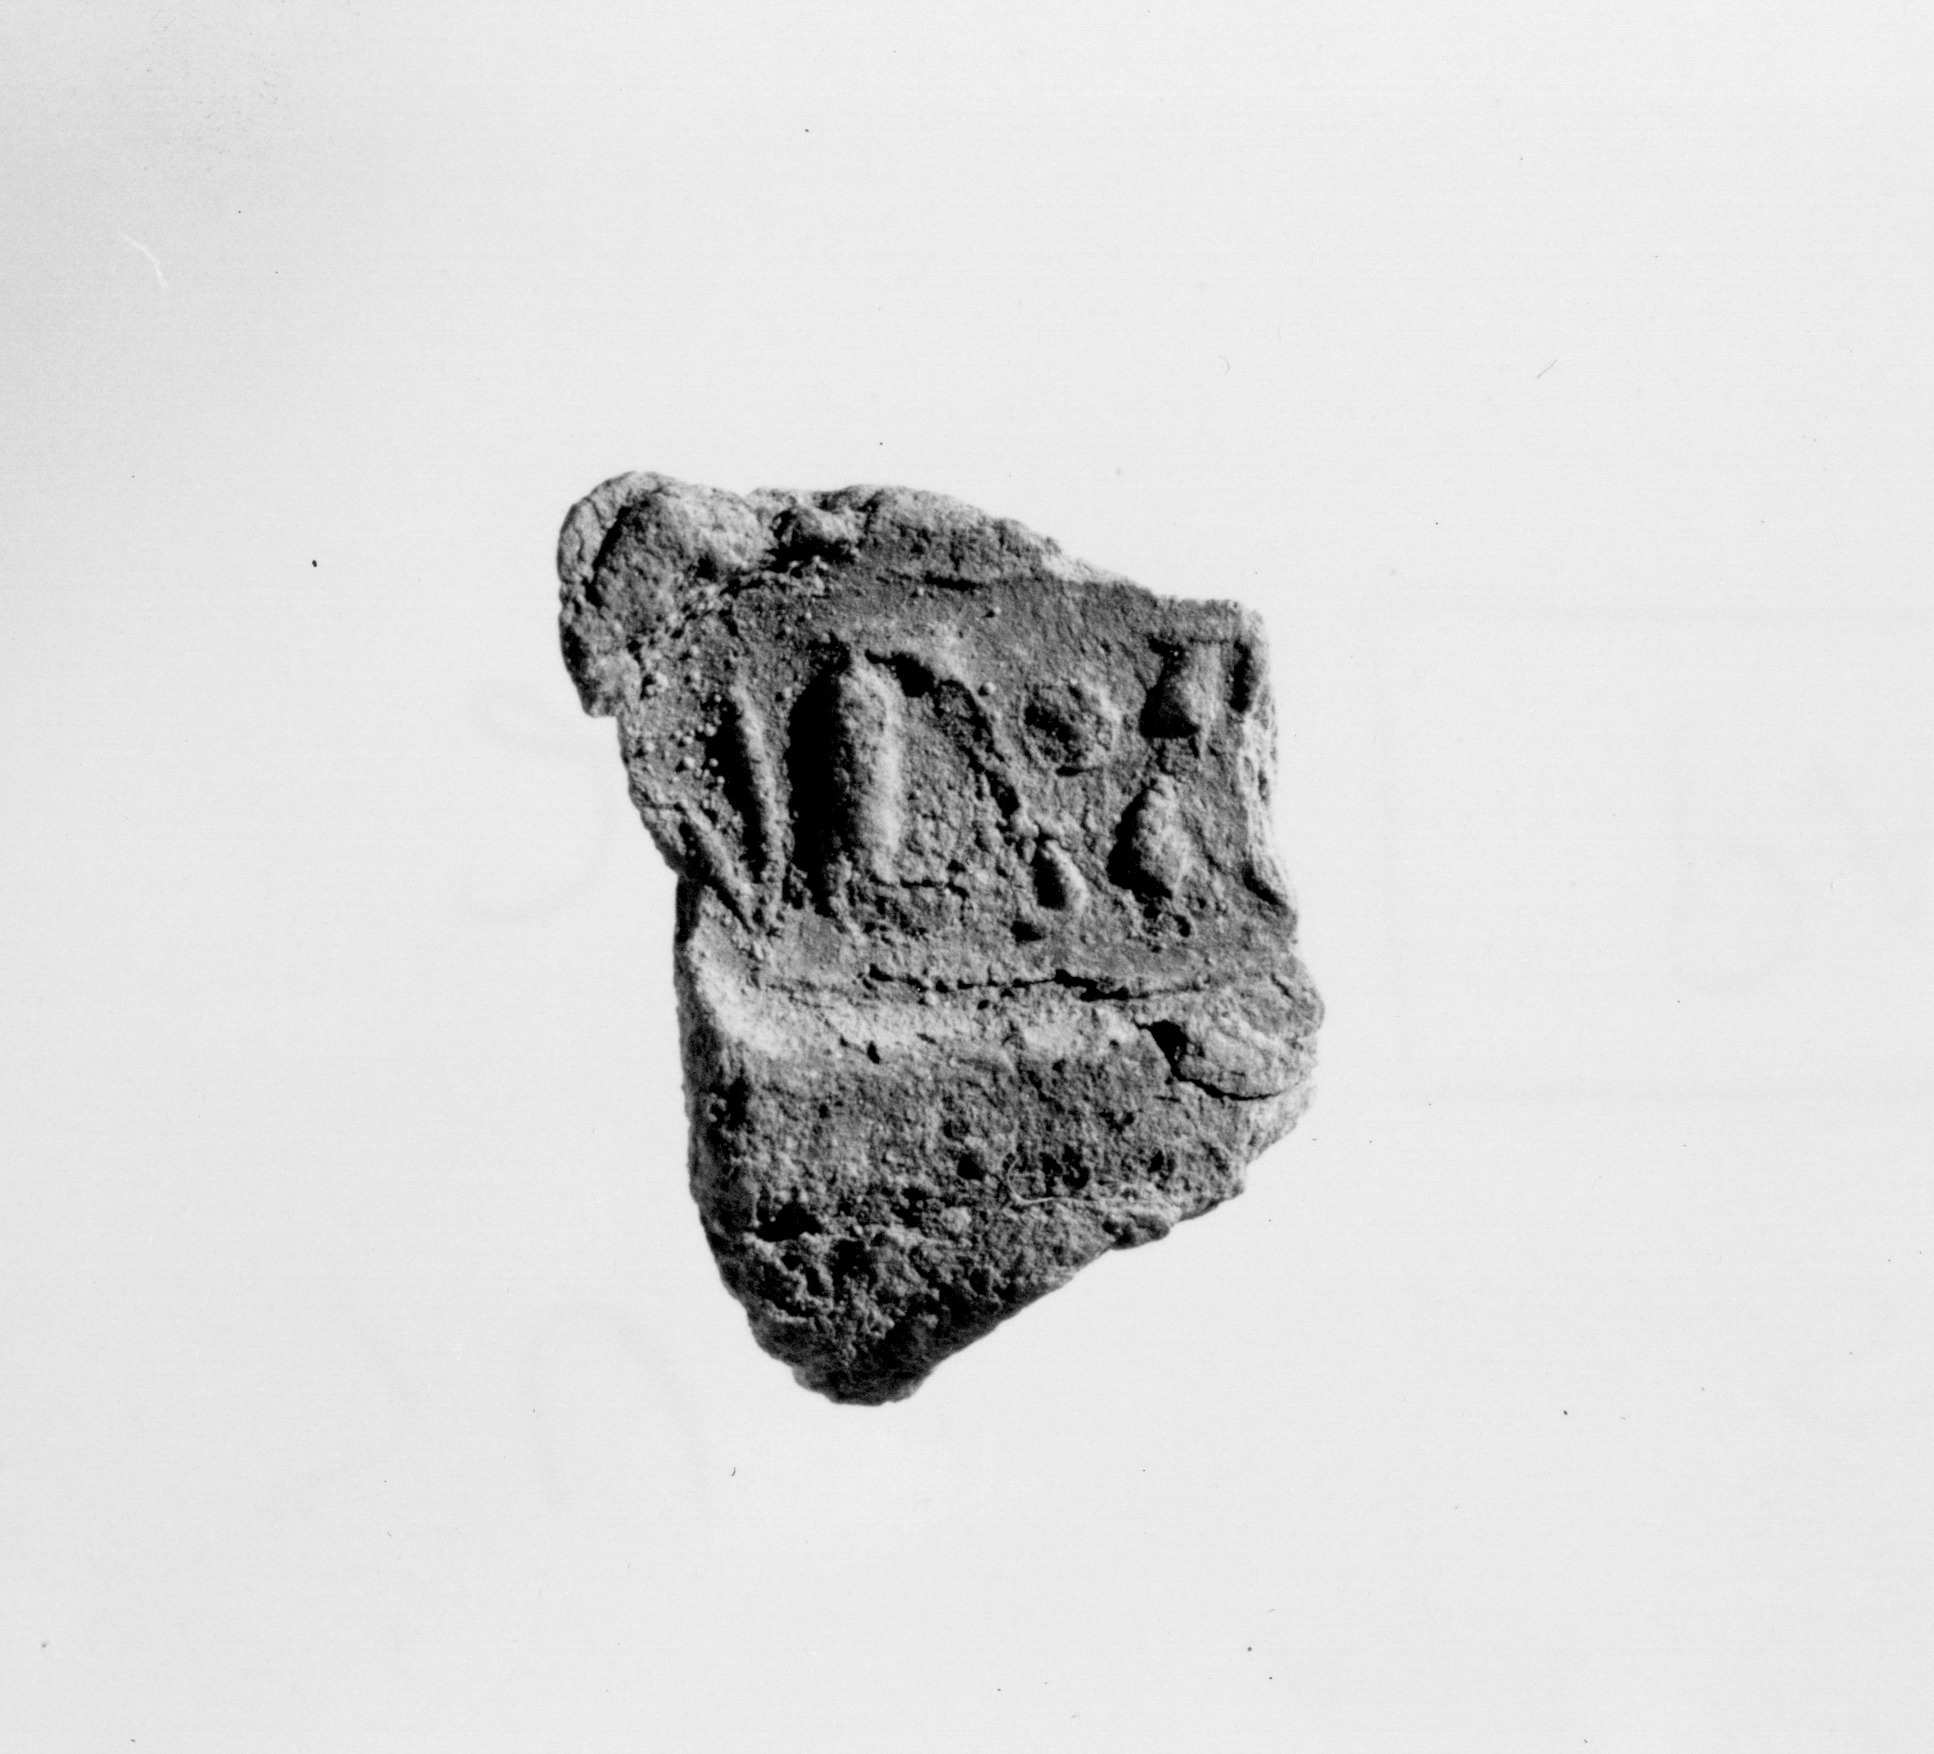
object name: sealing, nebmaatre, amenhotep iii, anubis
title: Document Sealing With the Throne Name of Amenhotep III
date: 1390-1352 BCE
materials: mud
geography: egypt